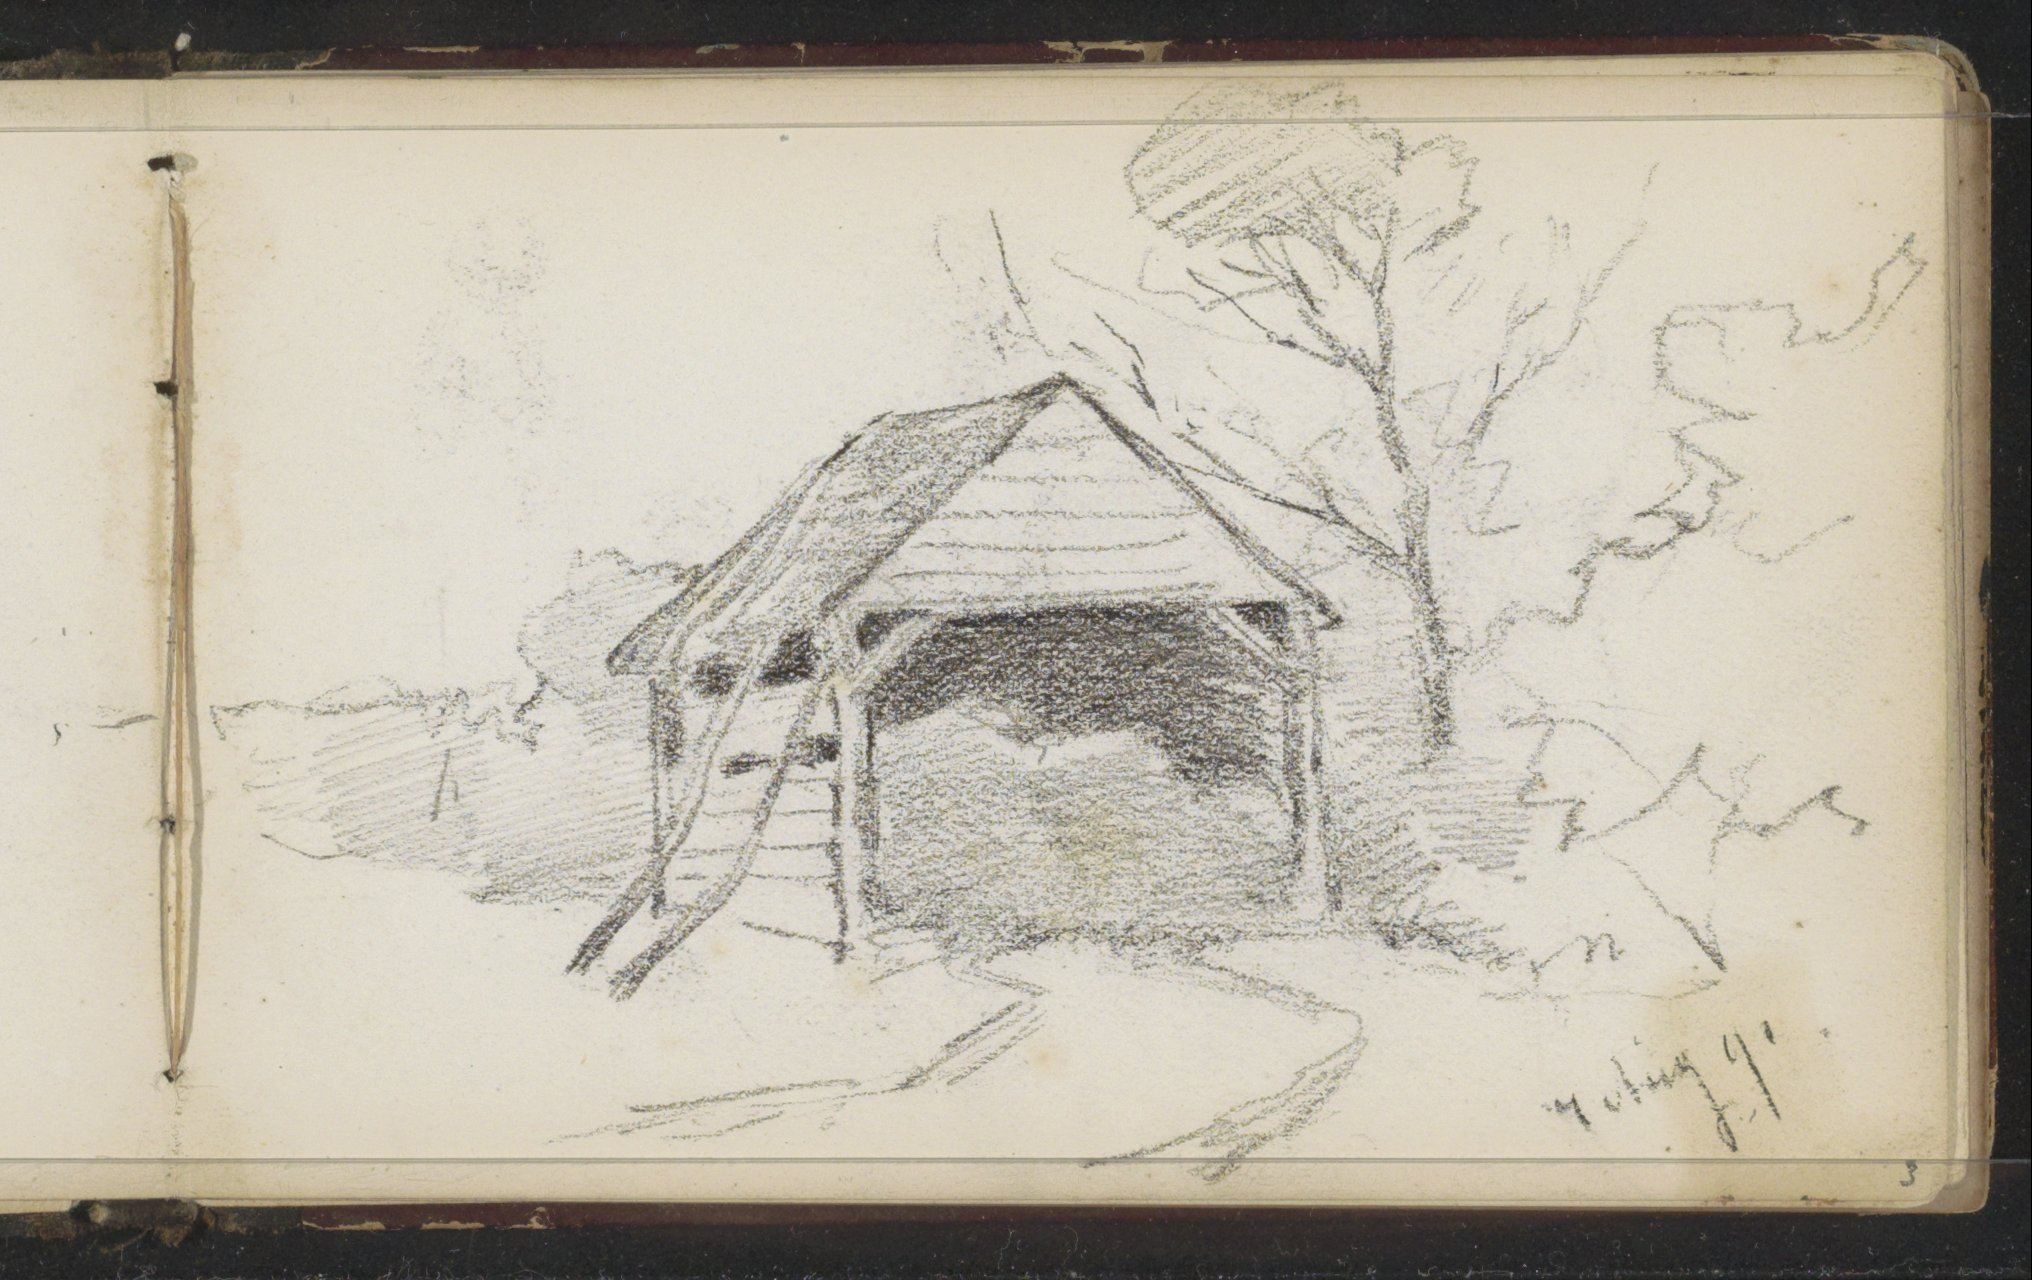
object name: sketchbook leaf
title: Schuur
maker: willem cornelis rip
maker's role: draughtsman, painter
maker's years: 1856-1922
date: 1808-1891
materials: chalk, paper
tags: shed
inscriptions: date: ‘7 Aug 91’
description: Blad 3 recto uit een schetsboek met 28 bladen.